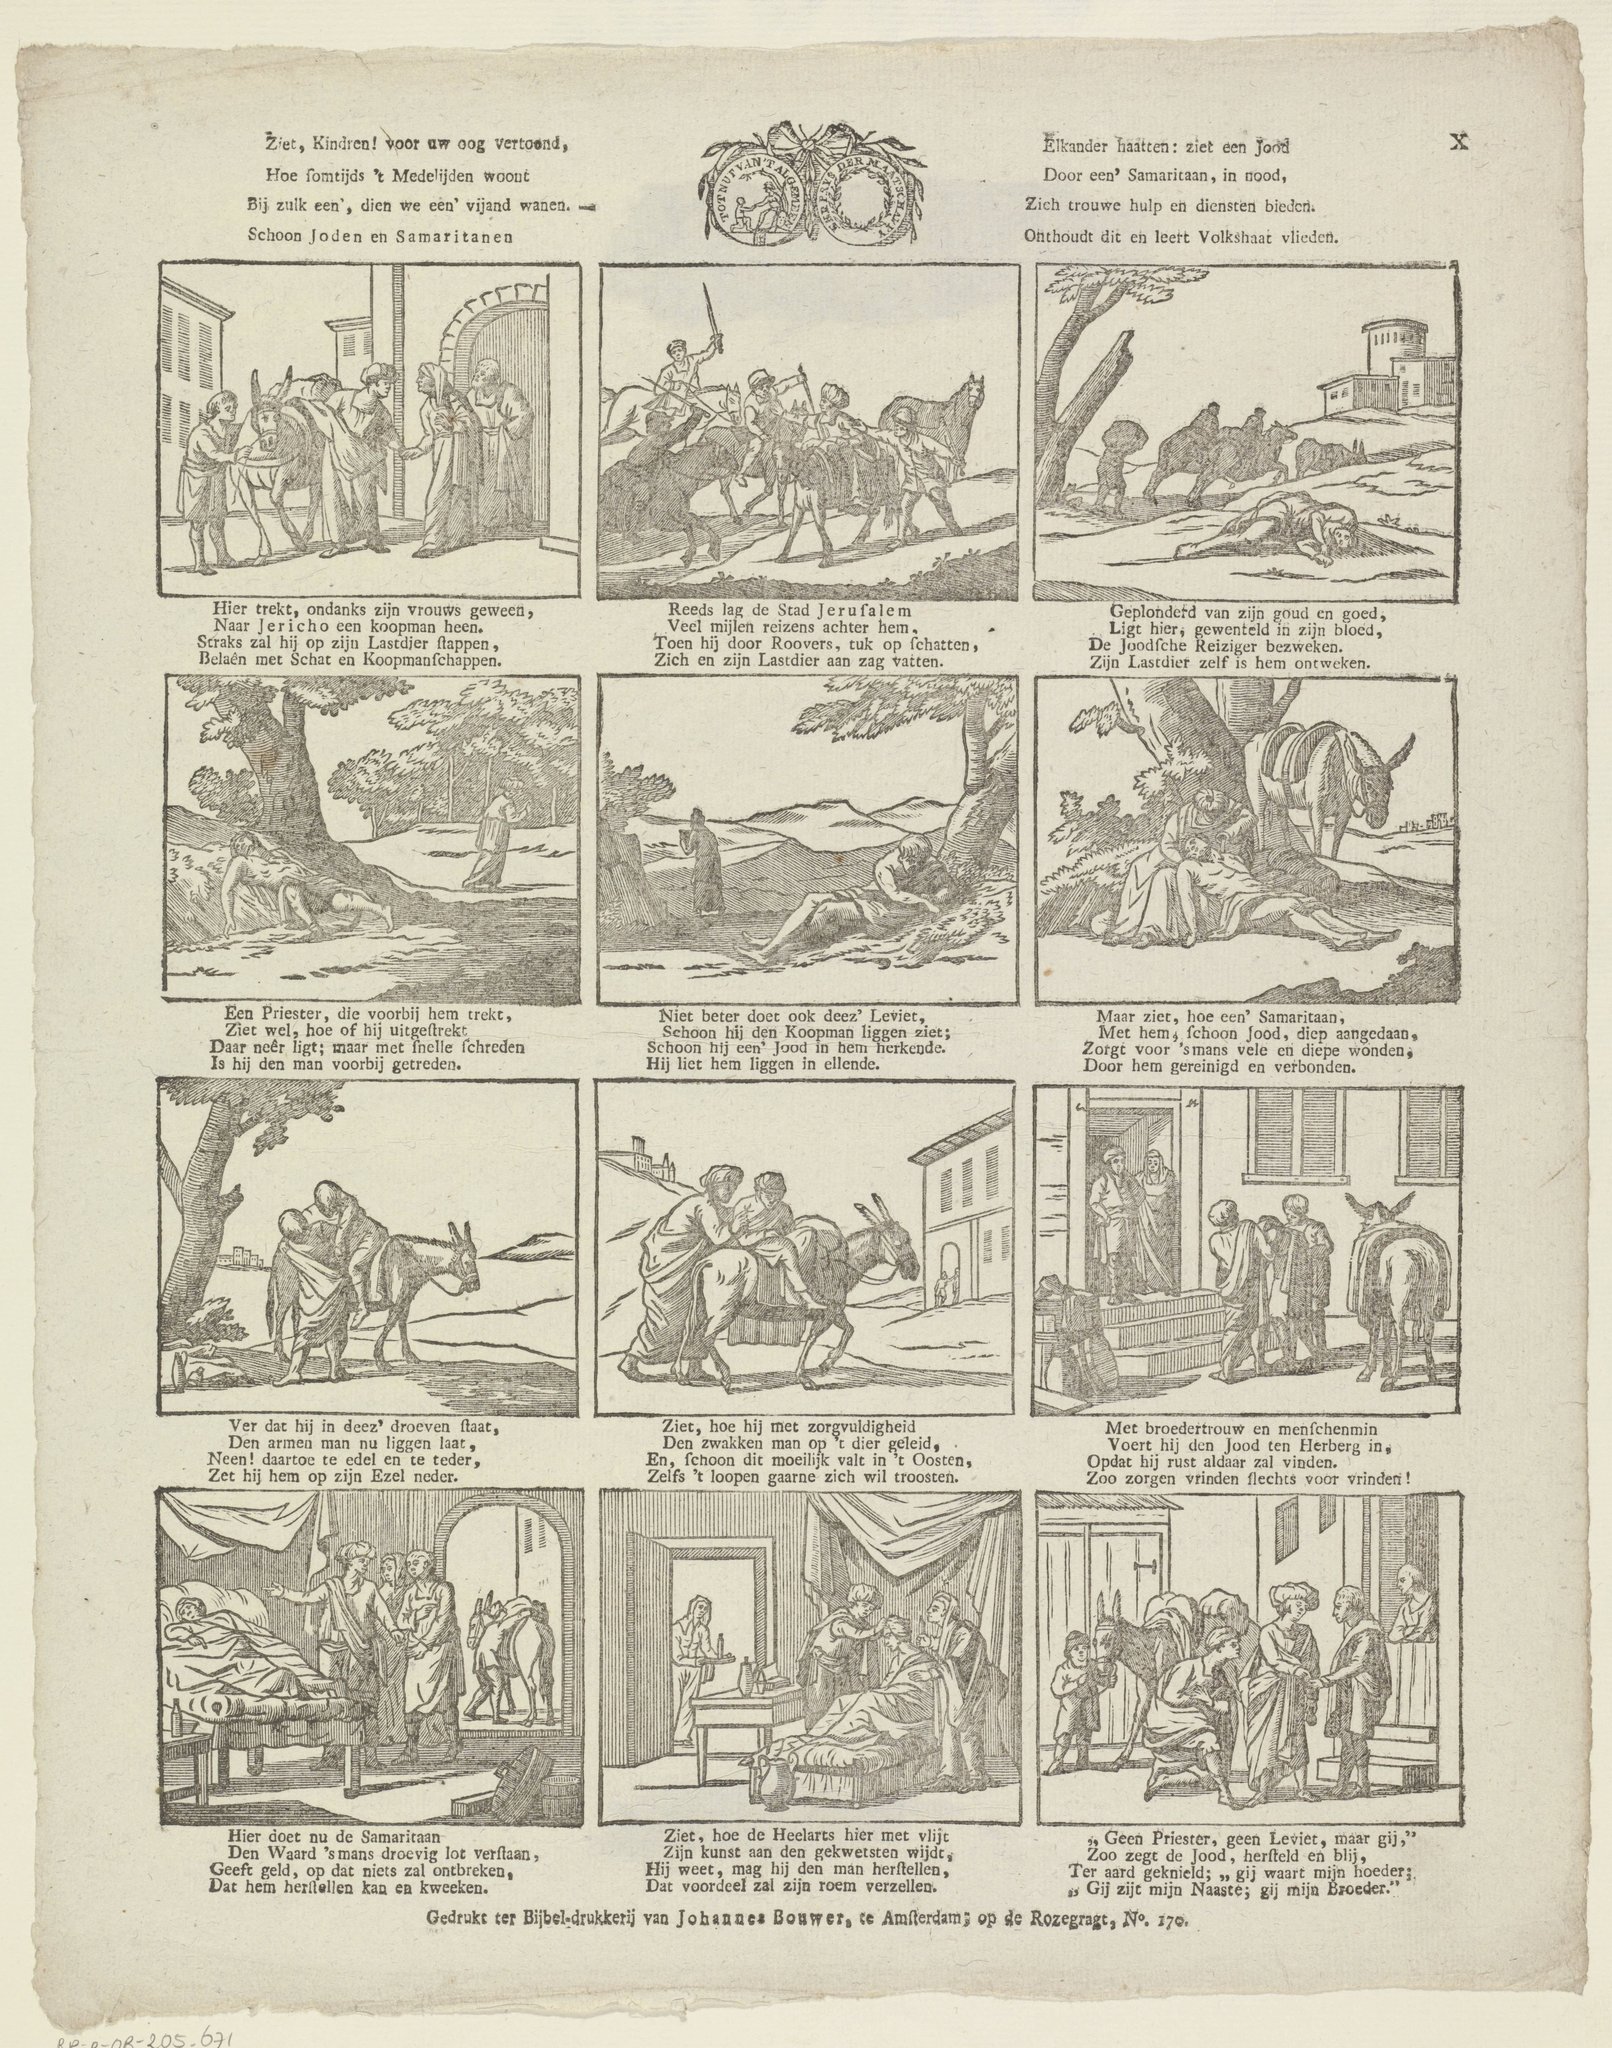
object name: popular print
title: Ziet kindren! voor uw oog vertoond, / Hoe somtijds 't medelijden woont [(...)]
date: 1805-1808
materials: paper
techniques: letterpress printing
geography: netherlands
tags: the good samaritan (luke 10:30-37)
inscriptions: collector's mark: Lugt 2760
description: Blad met 12 voorstellingen van het verhaal van de Barmhartige Samaritaan. Midden boven het zegel van de Maatschappij tot Nut van 't Algemeen. Onder elke afbeelding een vierregelig vers. Genummerd rechtsboven: X.